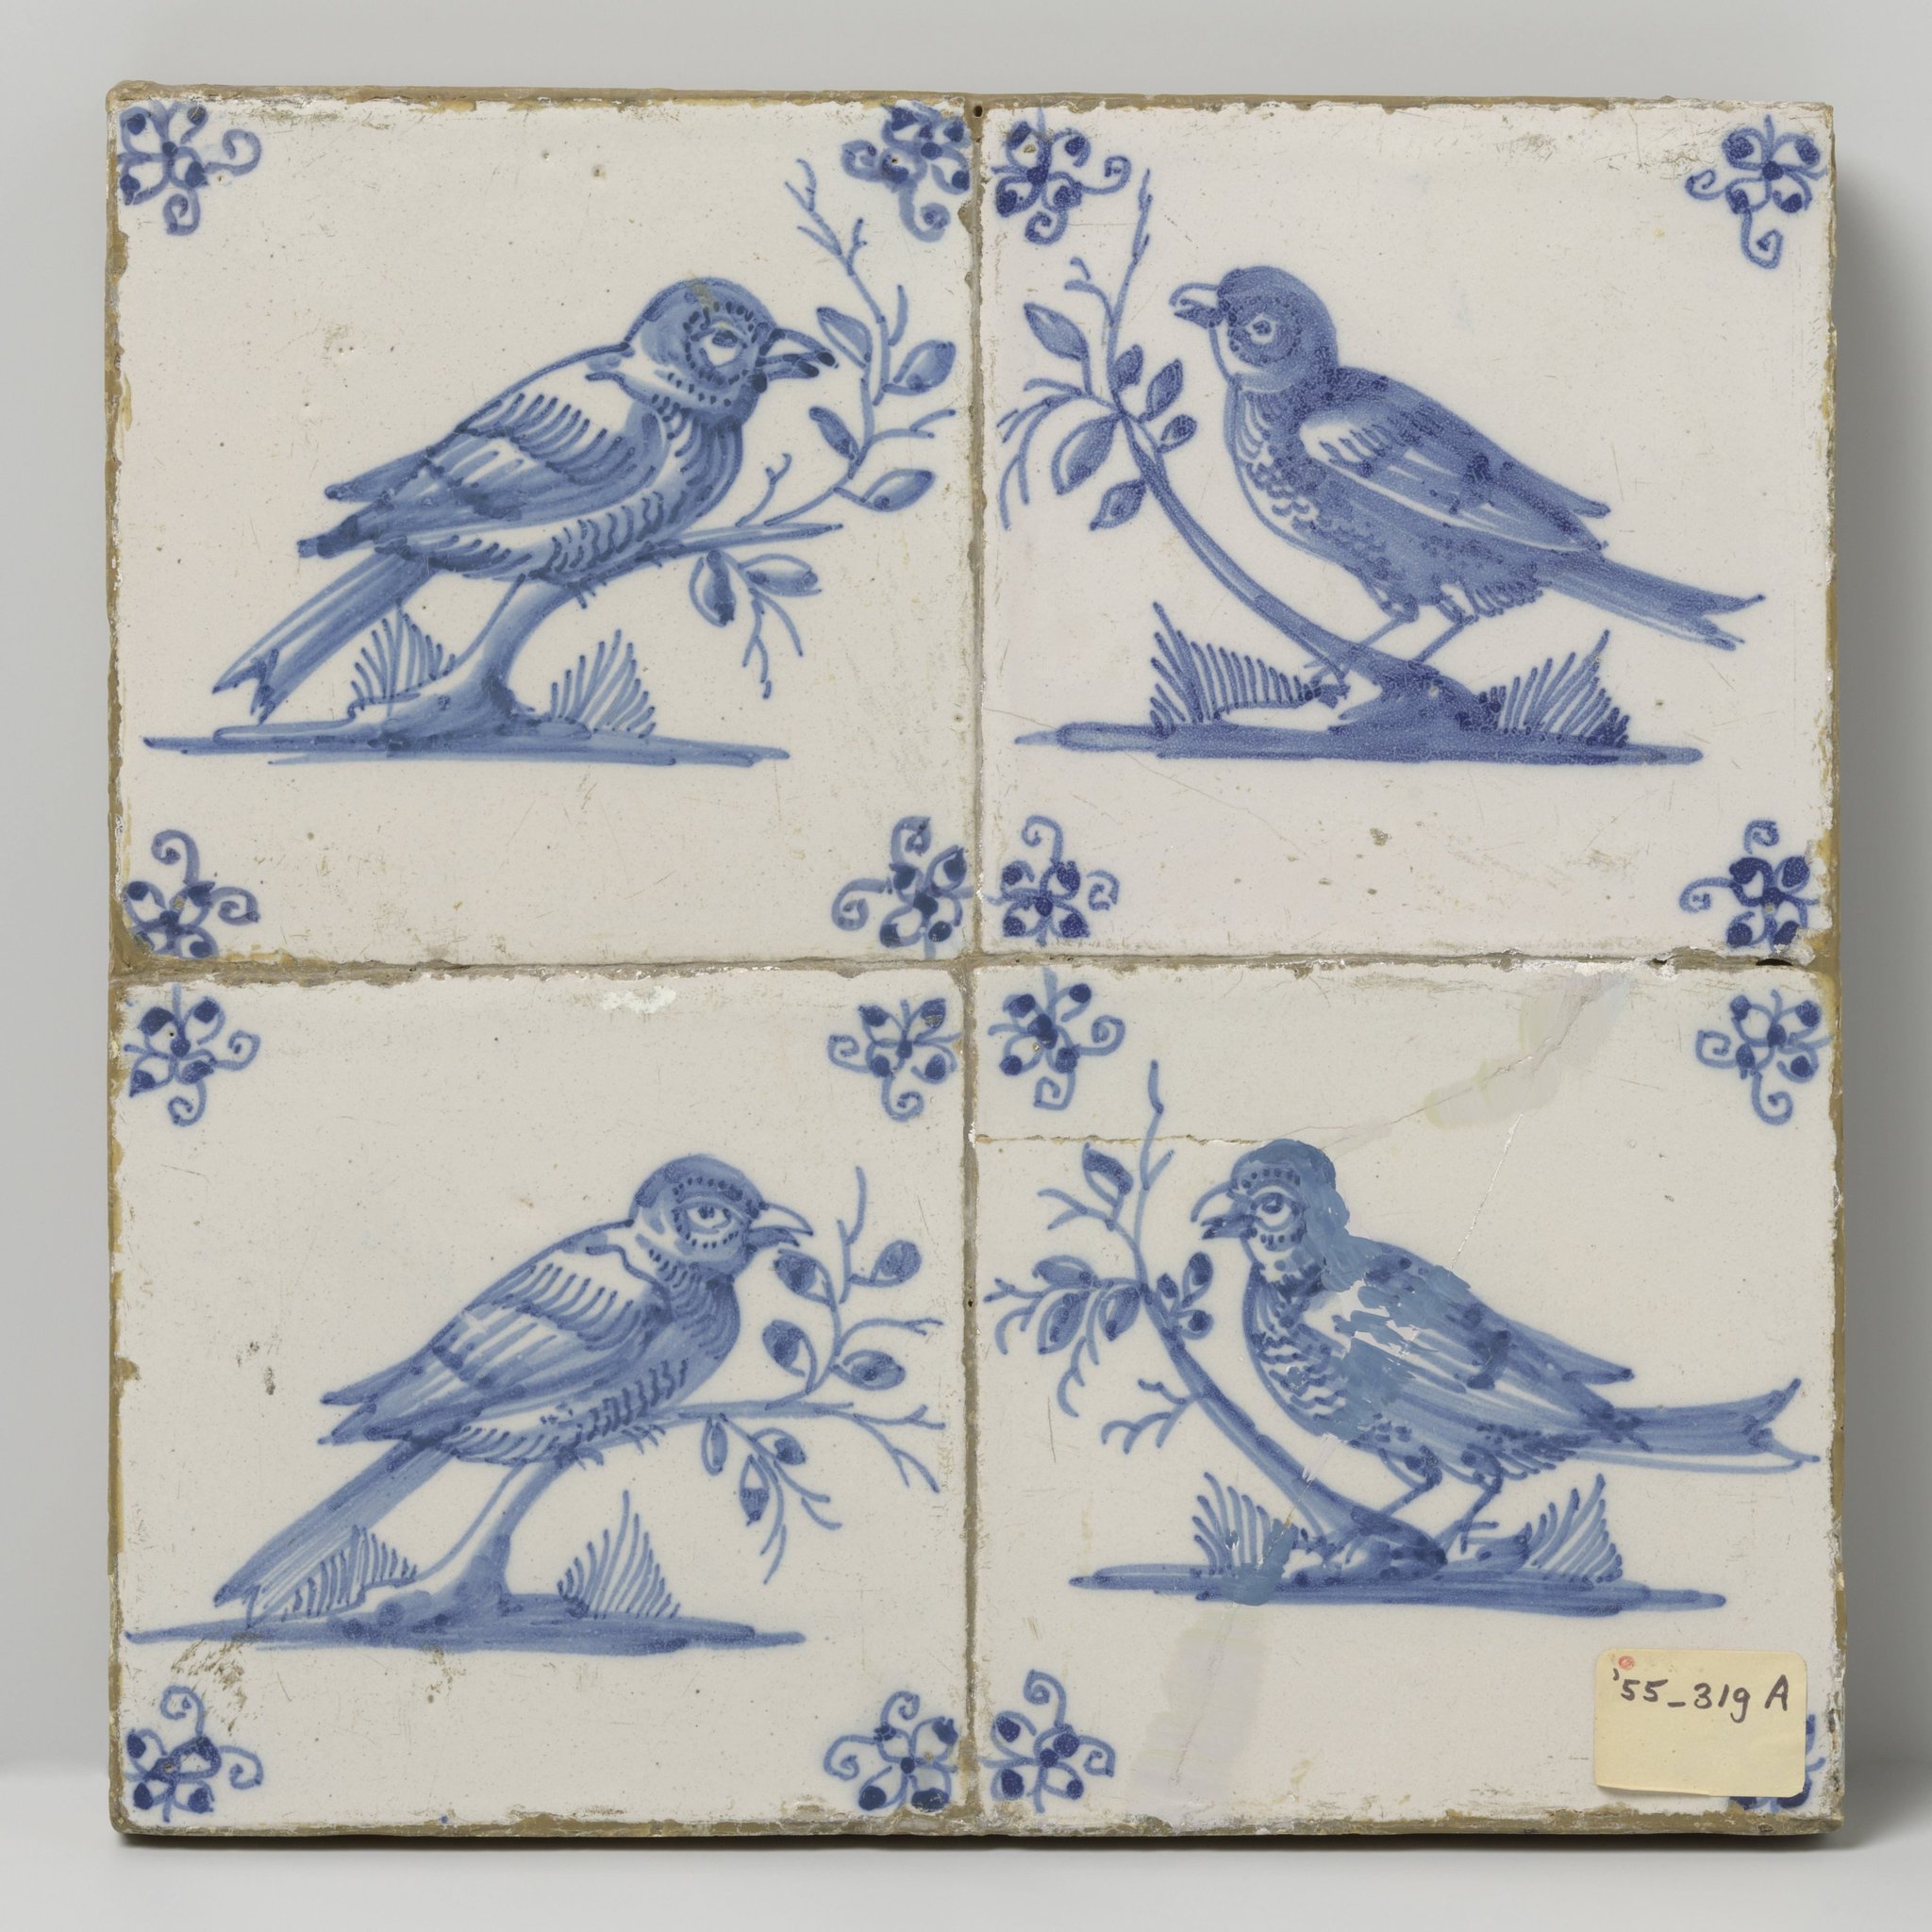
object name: diertegel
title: Veld van vier tegels met vogels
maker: Anonymous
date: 1635-1670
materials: earthenware, glaze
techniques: maiolica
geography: netherlands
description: Veld van vier tegels (2 x 2) elk met een blauw geschilderde vogel en in de hoeken, een spinnetje.